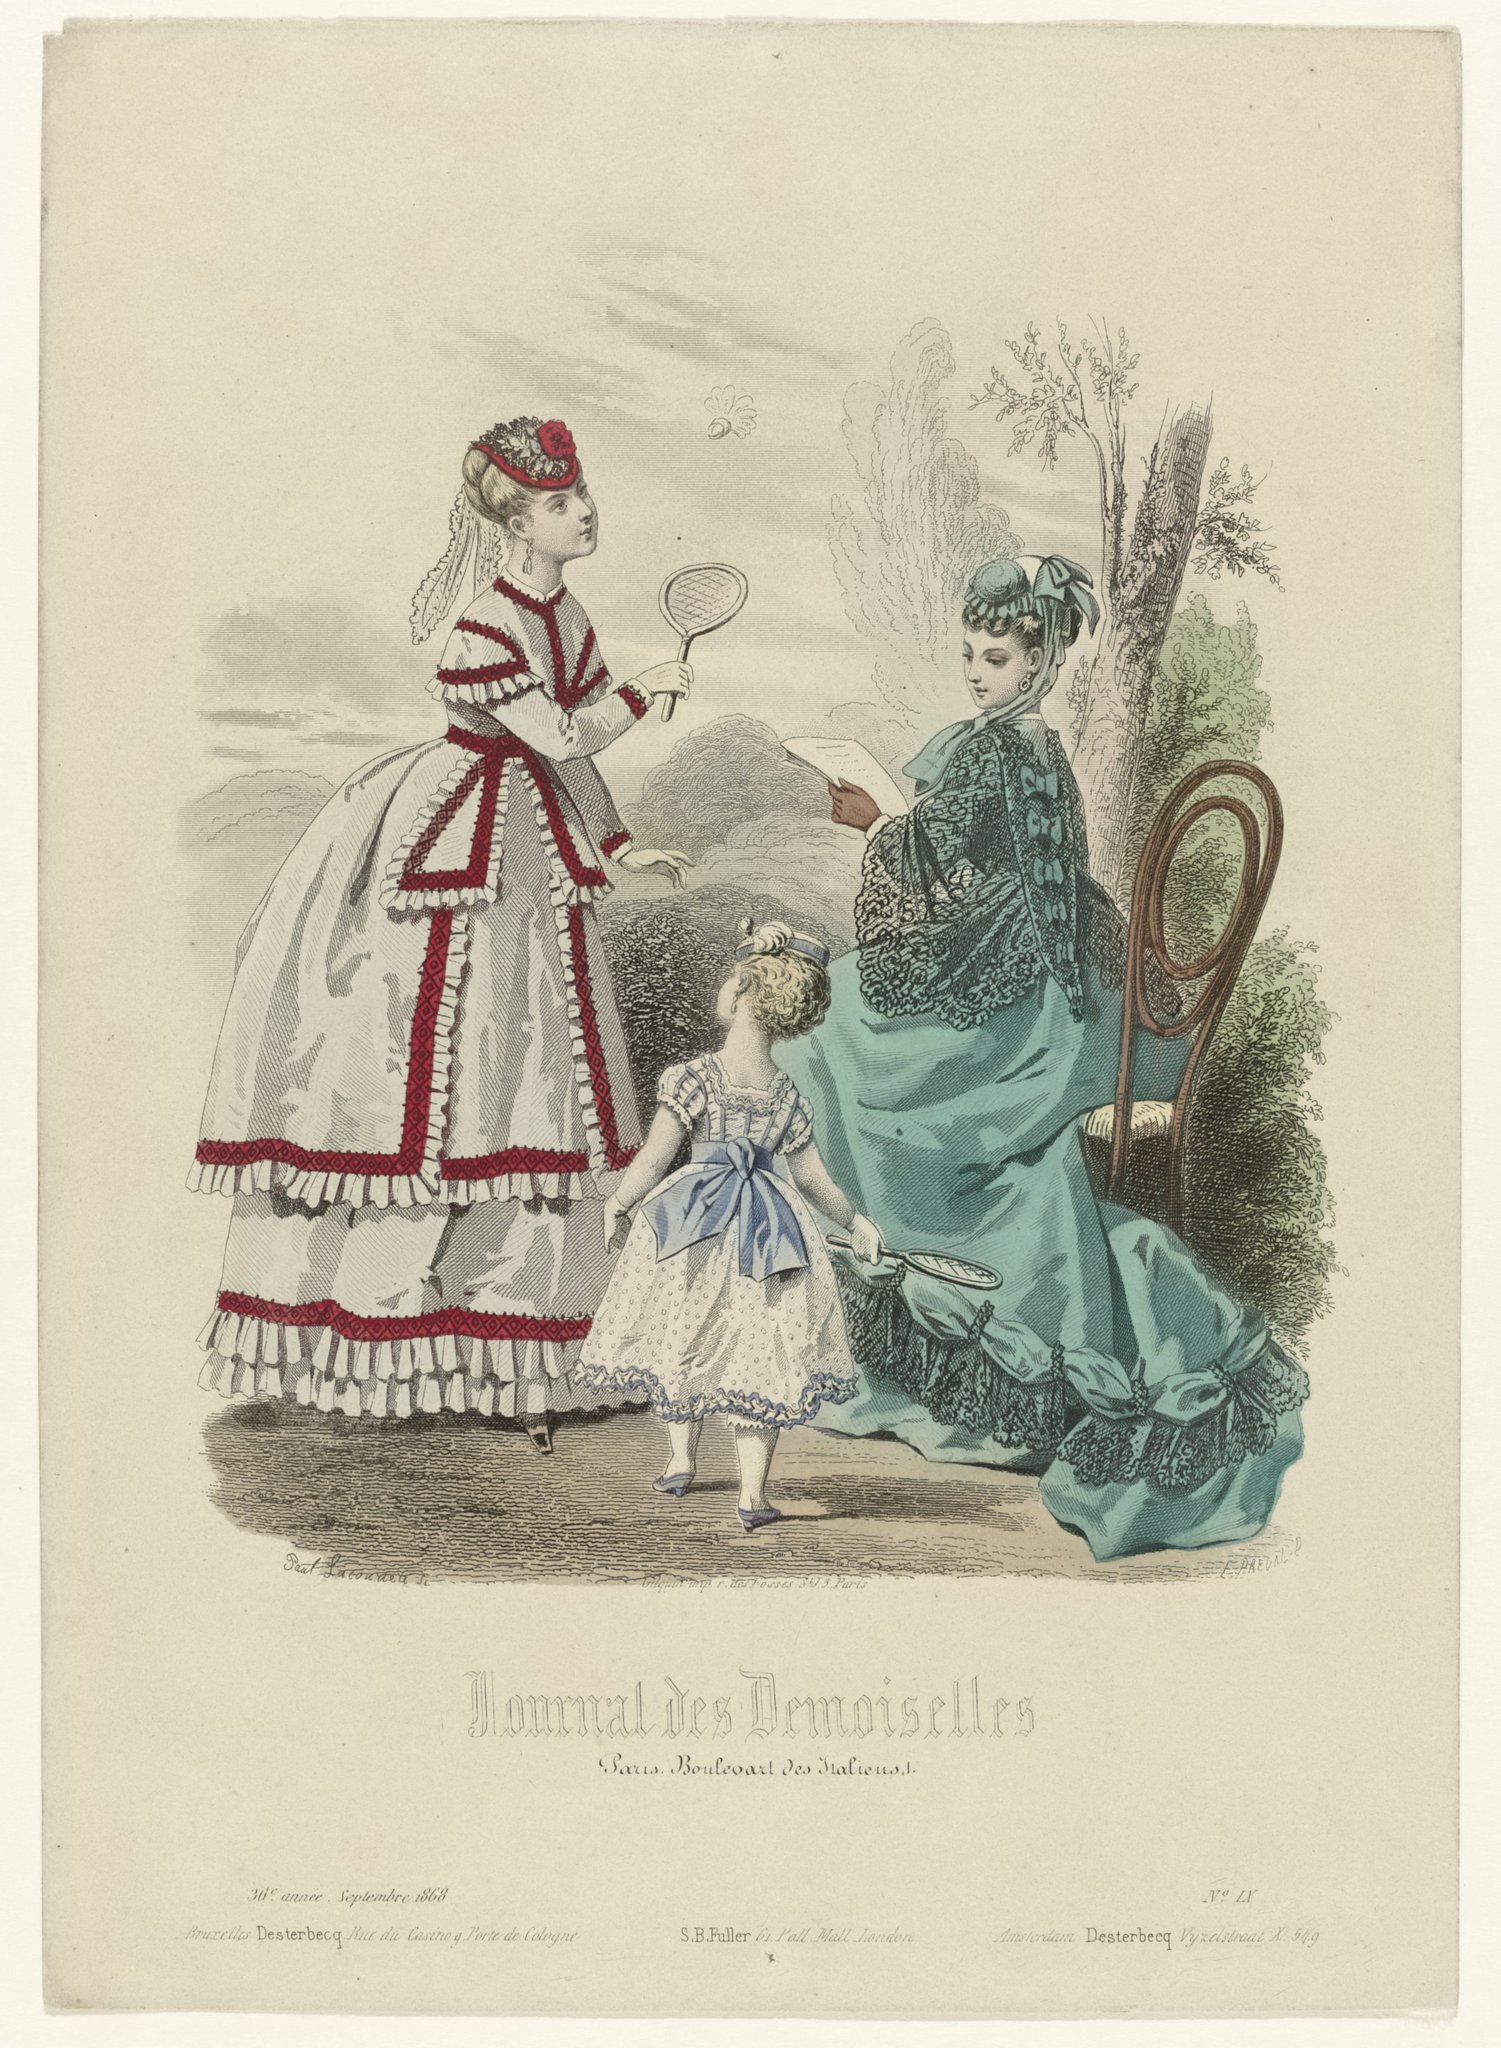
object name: fashion print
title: Journal des Demoiselles, septembre 1868, 36e année, No. 9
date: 1868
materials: paper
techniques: engraving, hand coloring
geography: paris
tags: bow (ornamental part of clothing) (+ women's clothes), head-gear: hat (+ girls' clothes), clothing for the upper part of the body (mantelet) (+ women's clothes), 'jeu de volant', badminton, fashion plates, head-gear: hat (+ women's clothes), dress, gown (+ girls' clothes)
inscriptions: address: ‘Paris, Boulevart des Italiens, 1.’, address: ‘Bruxelles Desterbecq Rue du Casino 9. Porte de Cologne / S.B. Fuller 61 Pall Mall London / Amsterdam Desterbecq Vijzelstraat X 549’, title: ‘Journal des Demoiselles’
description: Een vrouw en een meisje spelen badminton. Zij draagt een japon afgezet met ruches en rode bies. Kinderkleding: meisje in een gestippelde japon met ceintuur. Naast hun een zittende vrouw, op de rug gezien, in een mantille op een japon met sleep. Klein hoedje met striklinten. Prent uit het modetijdschrift Journal des Demoiselles (1833 -1922).